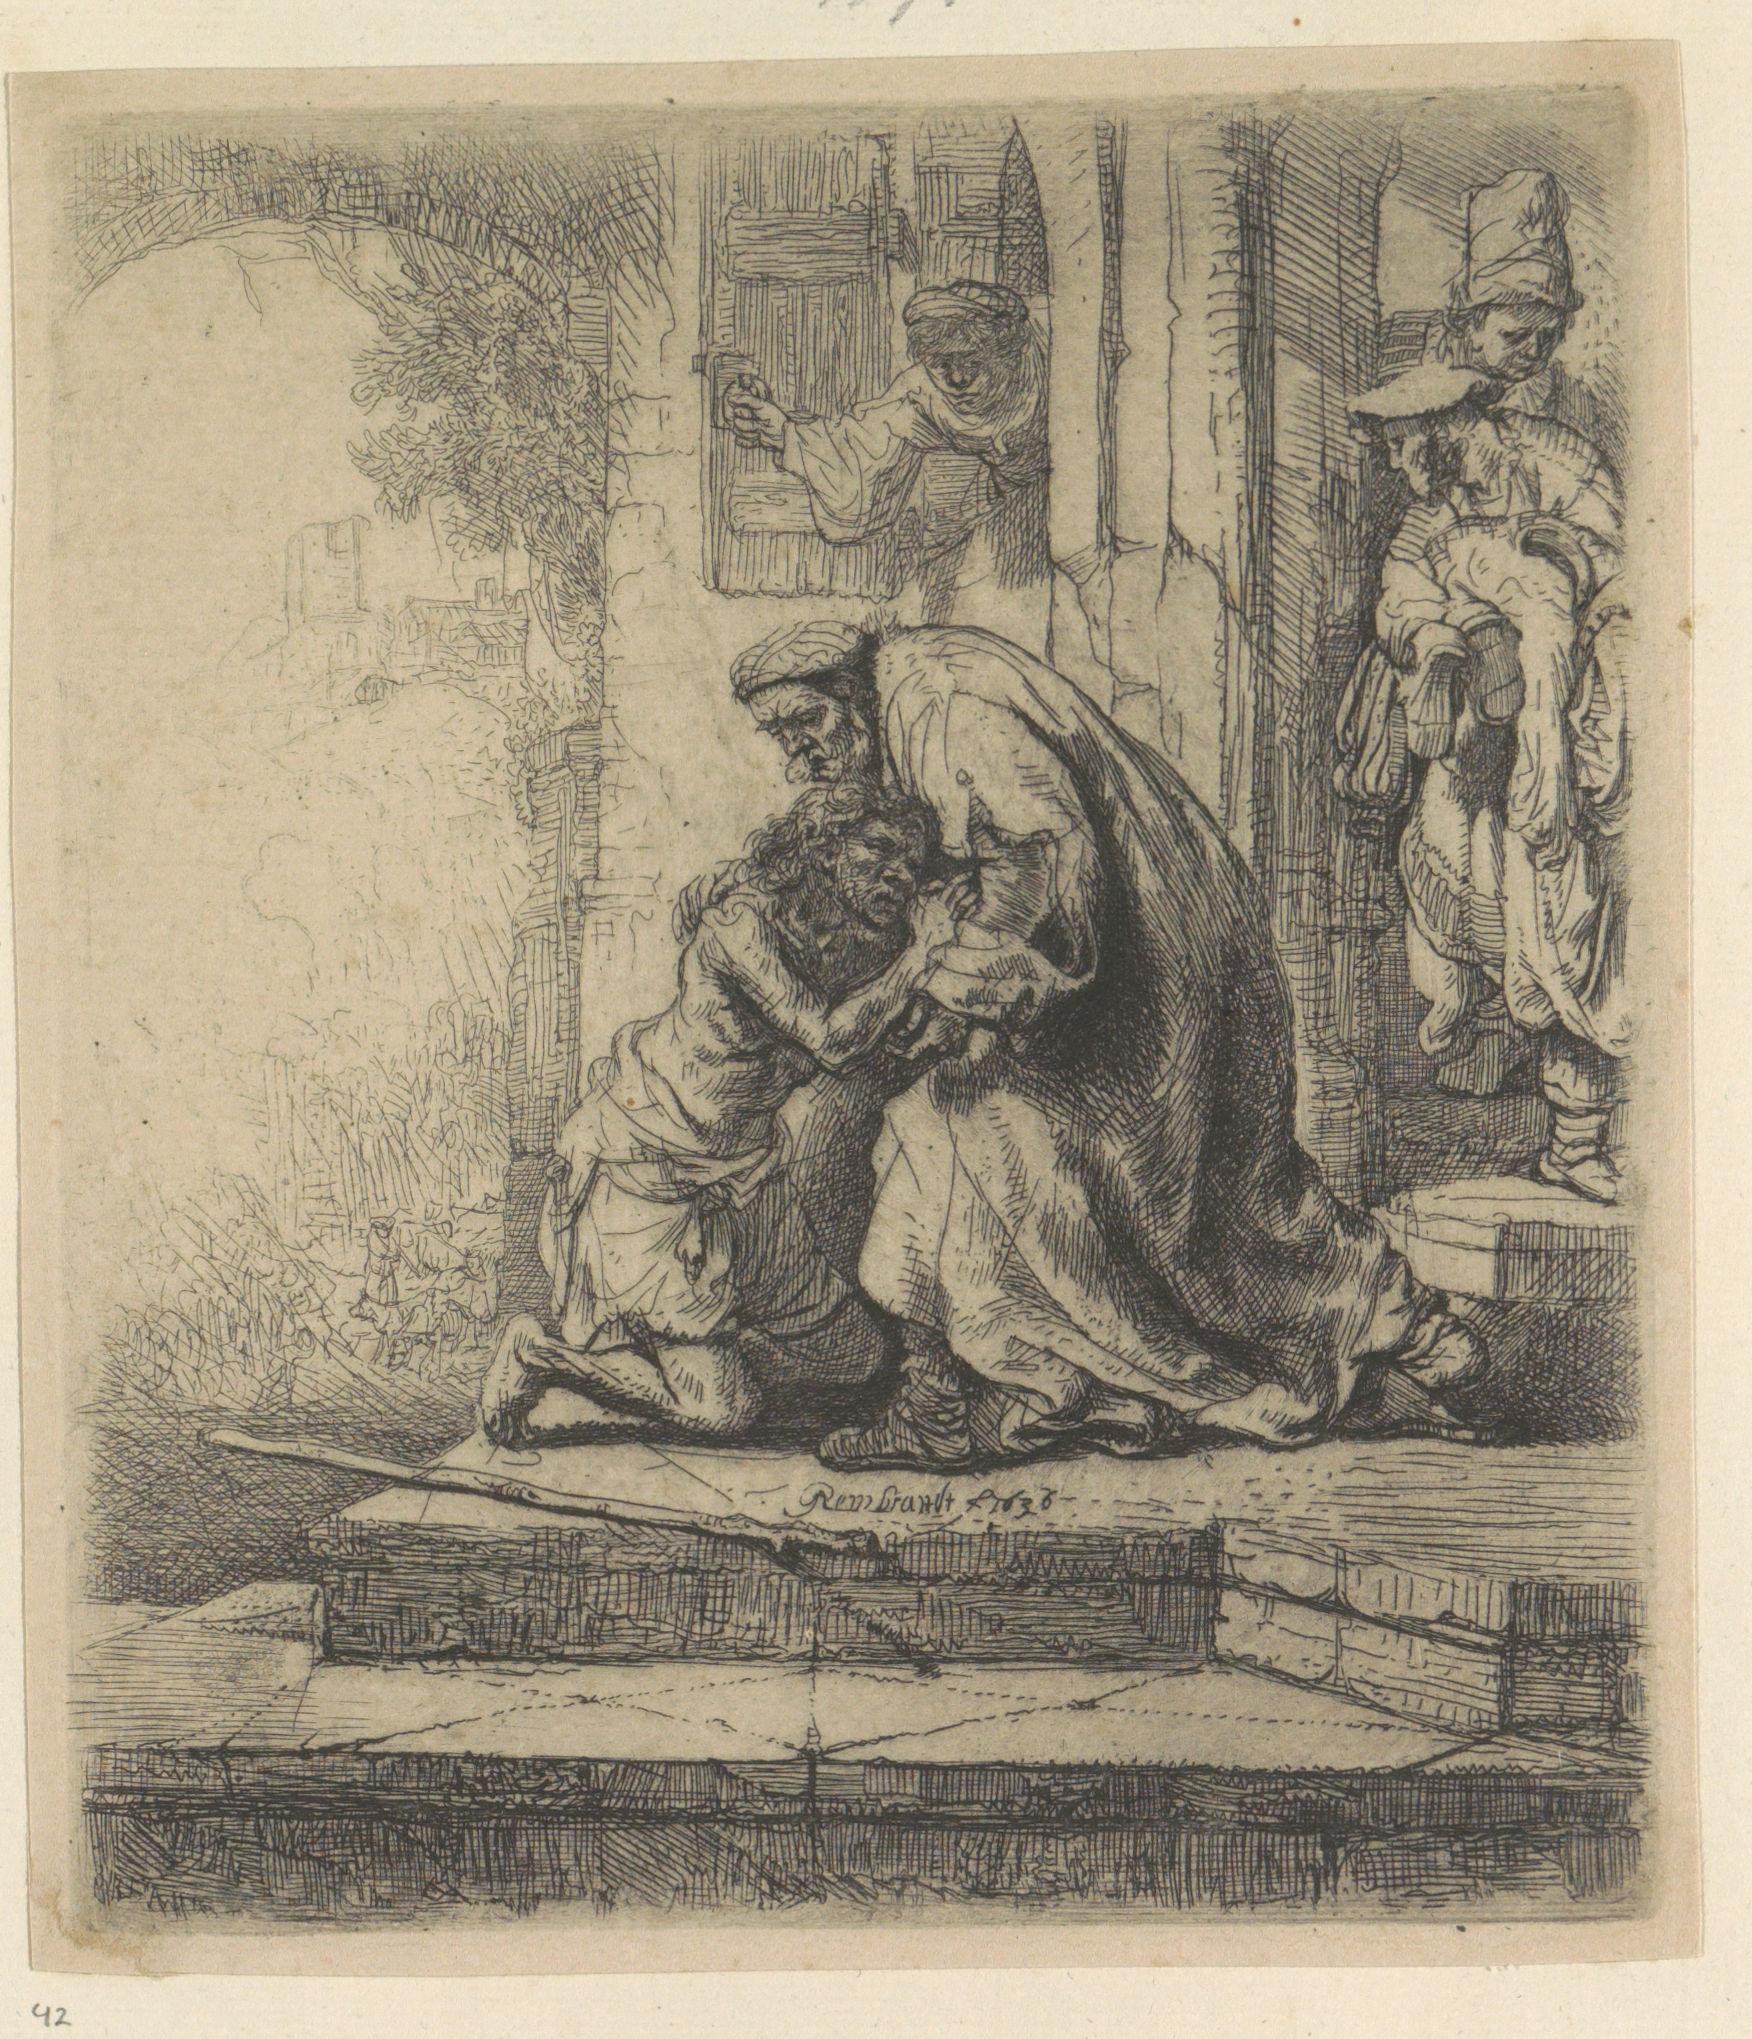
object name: print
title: Thuiskomst van de verloren zoon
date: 1636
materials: paper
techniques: etching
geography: paris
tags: the parable of the prodigal son (luke 15:11-32)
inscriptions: date